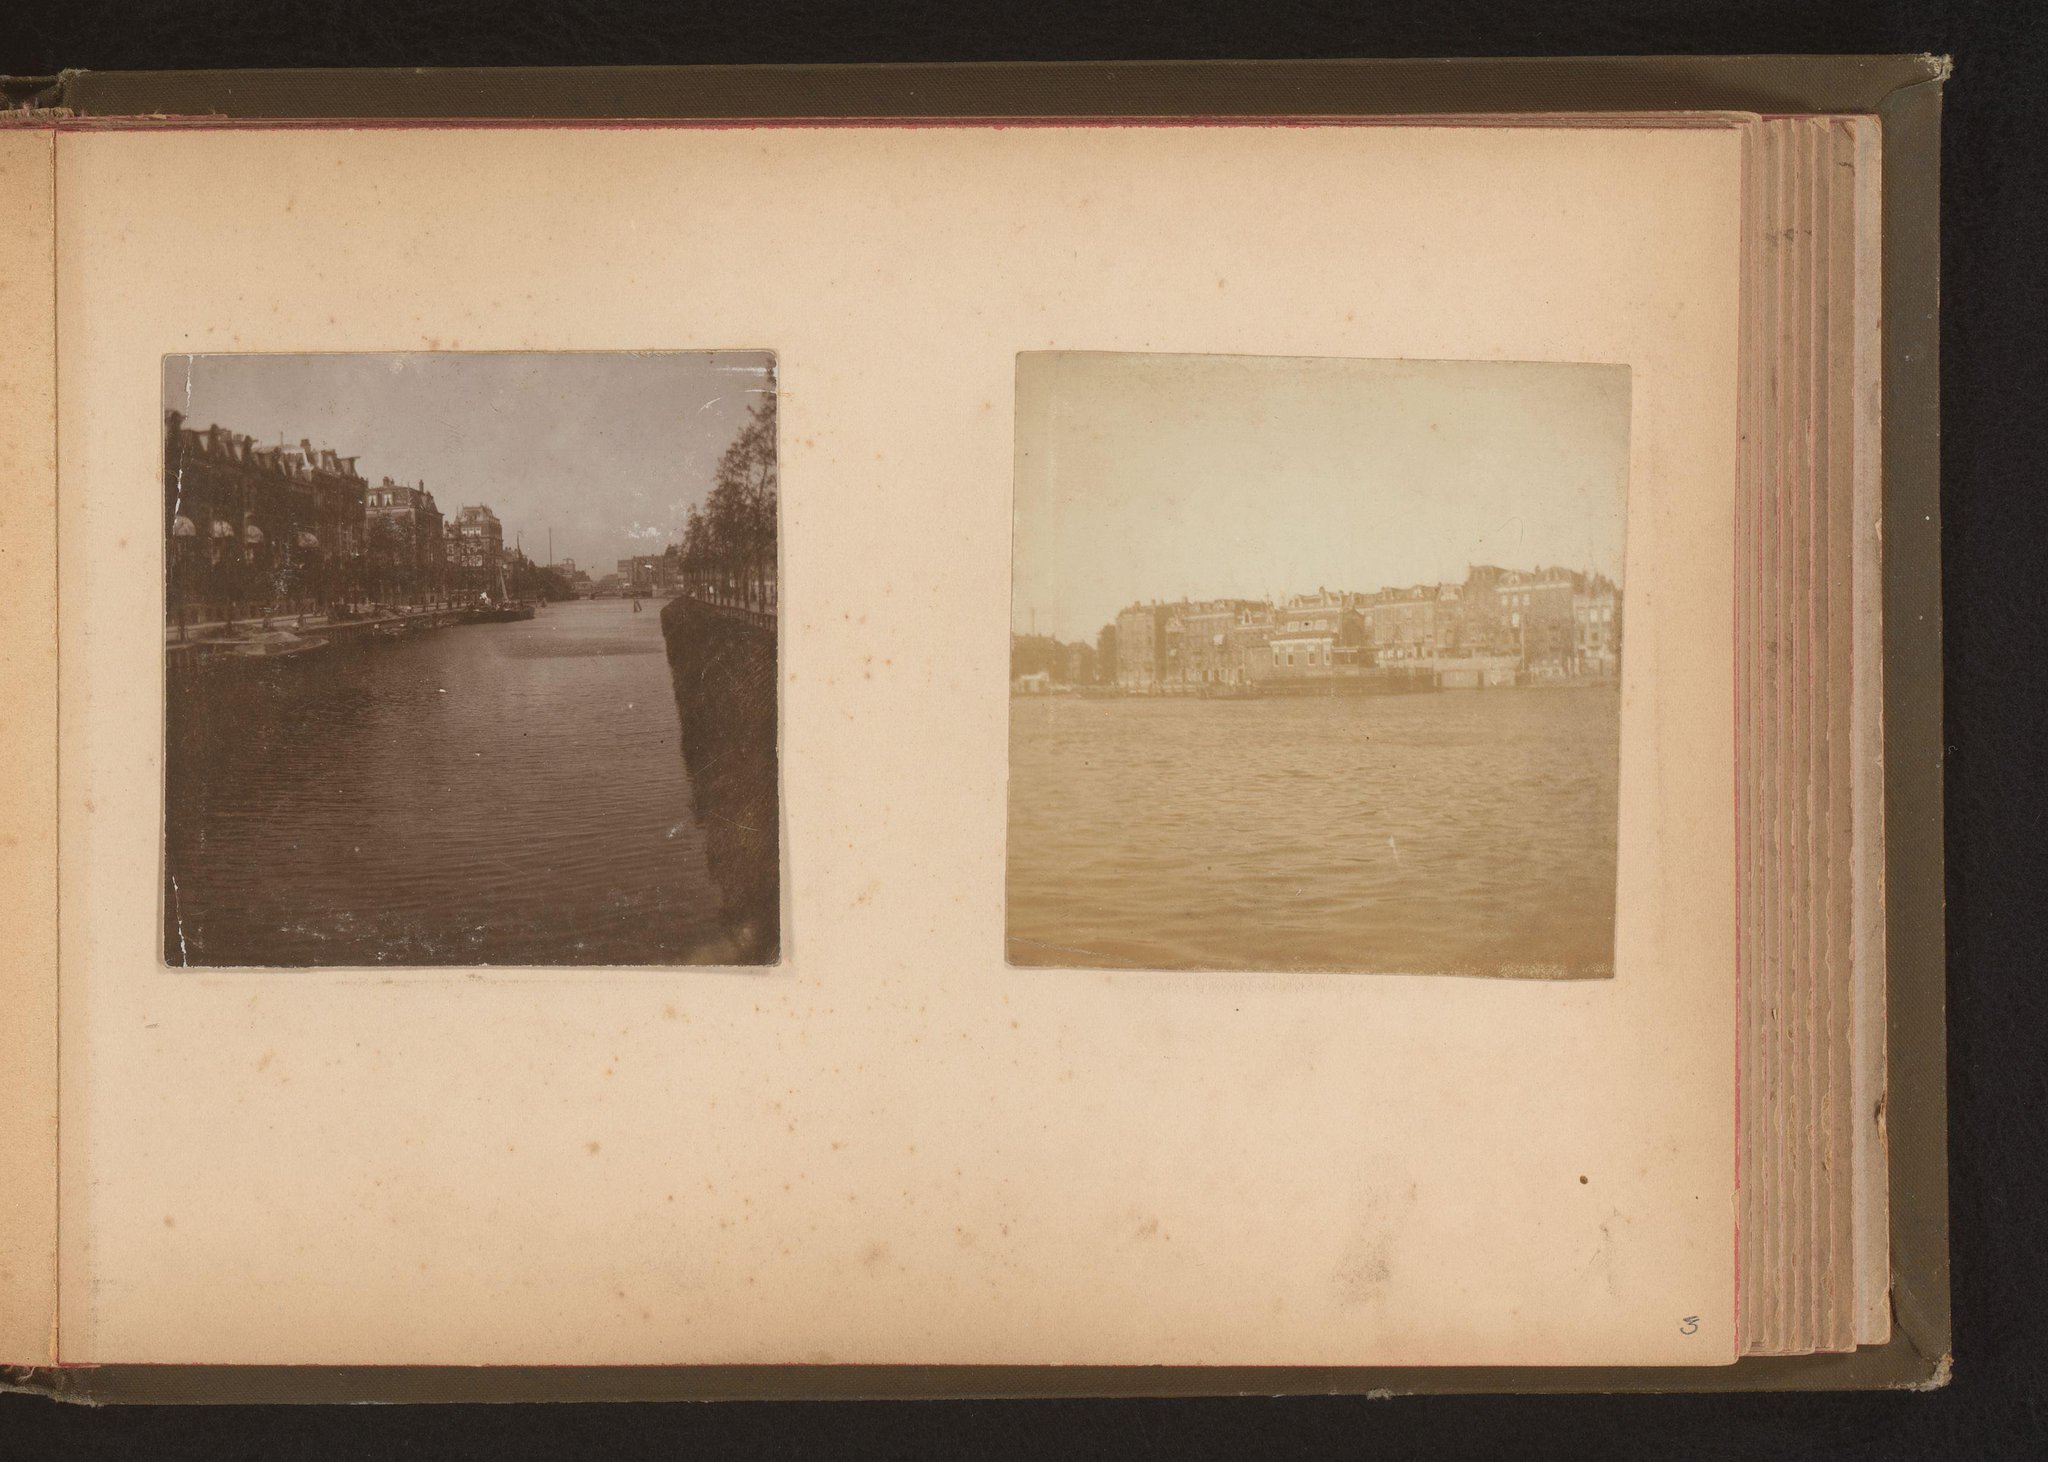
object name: photograph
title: Twee foto's van huizen langs de Amstel, Amsterdam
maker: Anonymous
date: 1895-1910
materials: paper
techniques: albumen print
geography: amsterdam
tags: urban housing, canals, waters (in city), amsterdam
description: Deze foto's maken deel uit van een album.